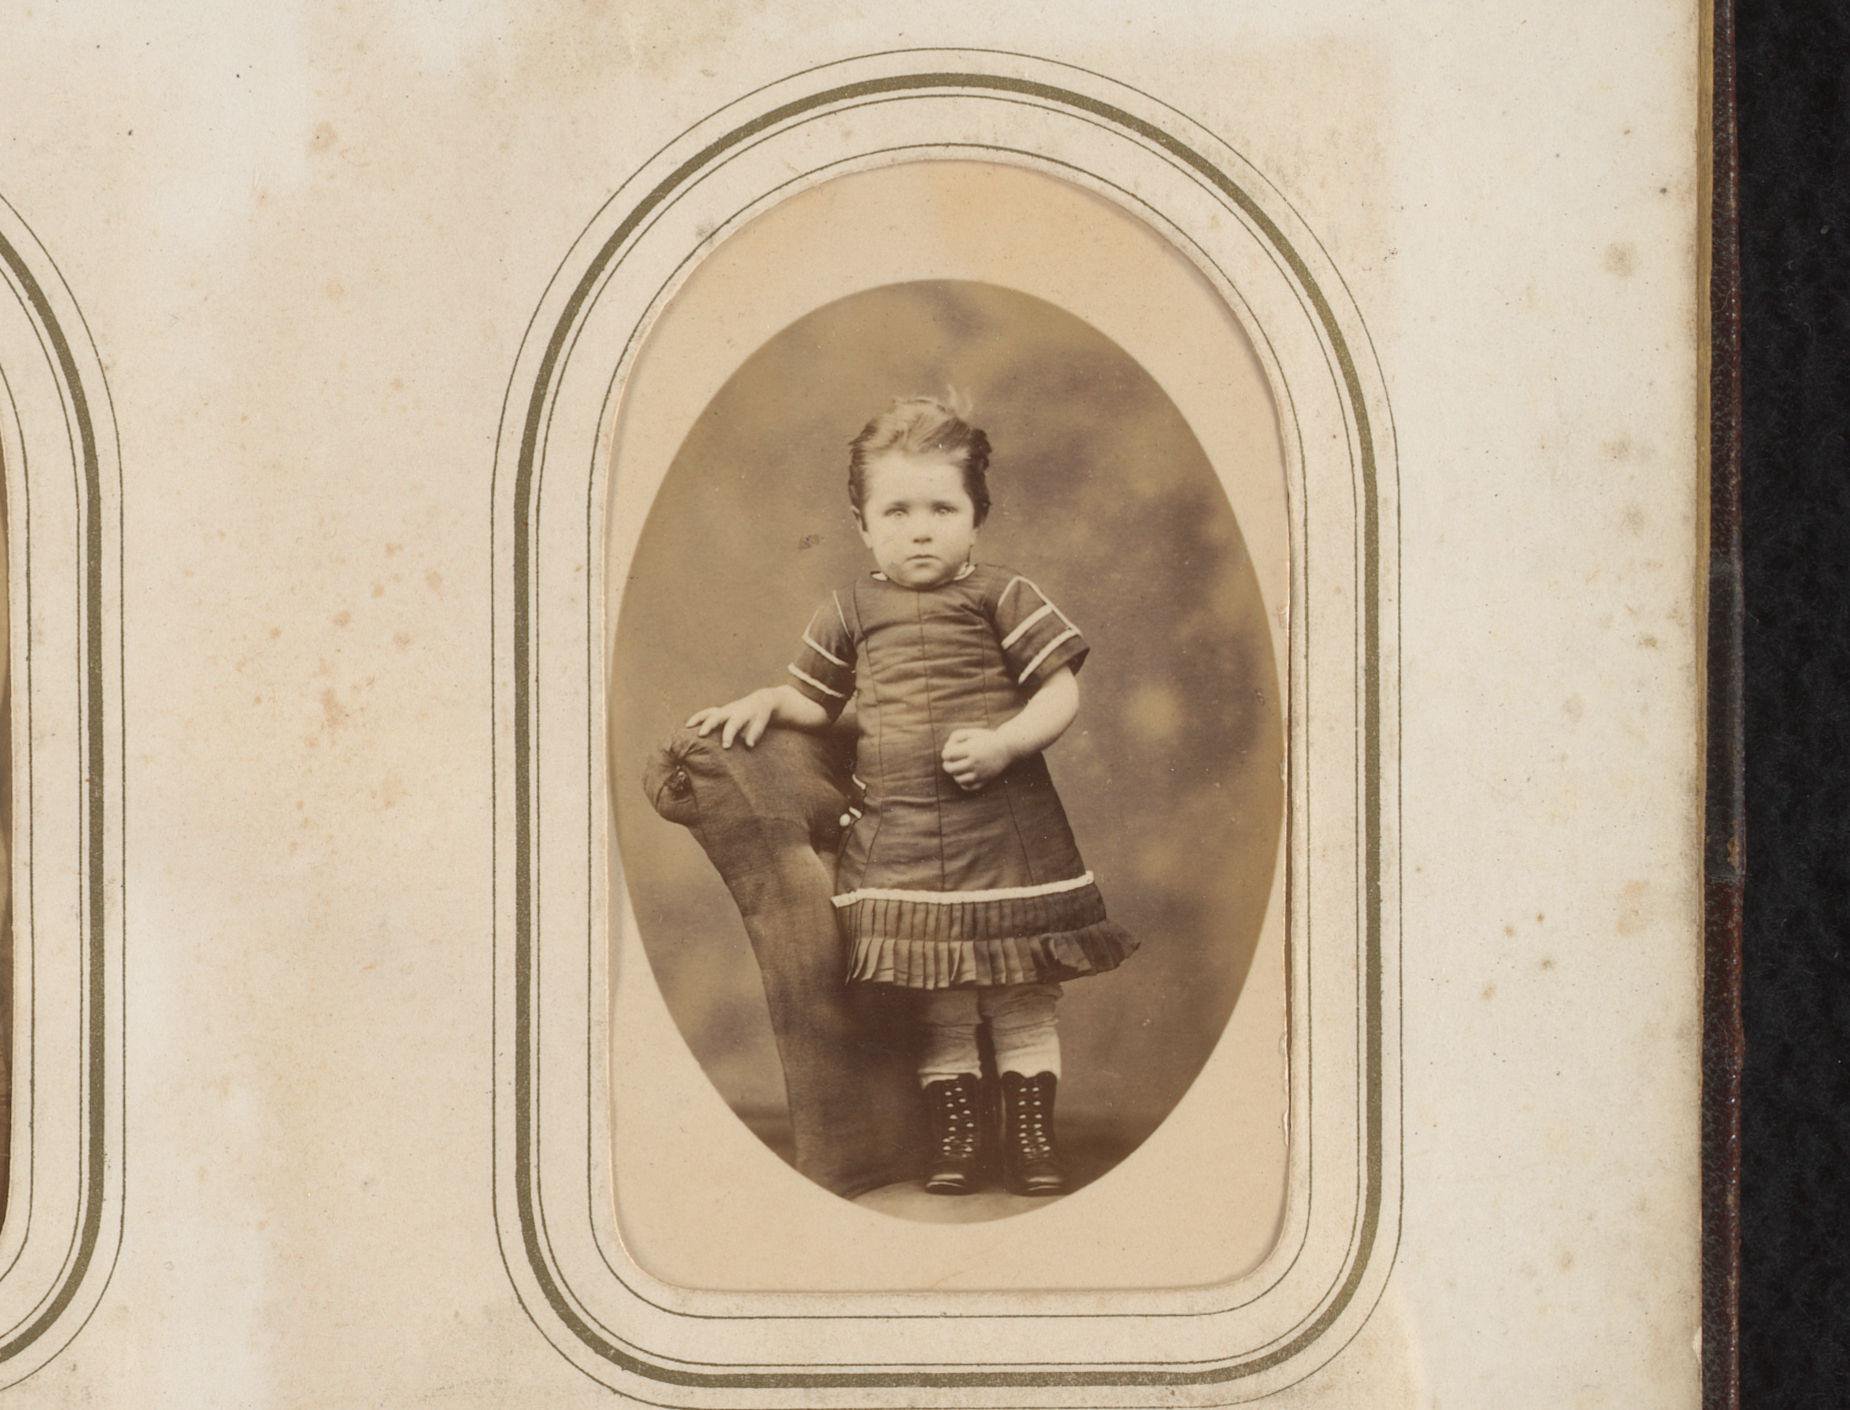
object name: photograph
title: Portret van een meisje, staand op een stoel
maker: jannis jacobus van melle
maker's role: fotograaf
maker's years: 1829-1911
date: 1877-1900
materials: cardboard, celluloid, photographic support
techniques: albumen print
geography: bergen op zoom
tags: historical persons - bb - woman, toddler (female), chair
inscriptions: inscription: ‘Photographisch/ ATELIER/ J.J. van Melle/ BERGEN/ OP/ ZOOM/ Rykebuurtstraat./ De plaat blyft voor nabestelling bewaard.’